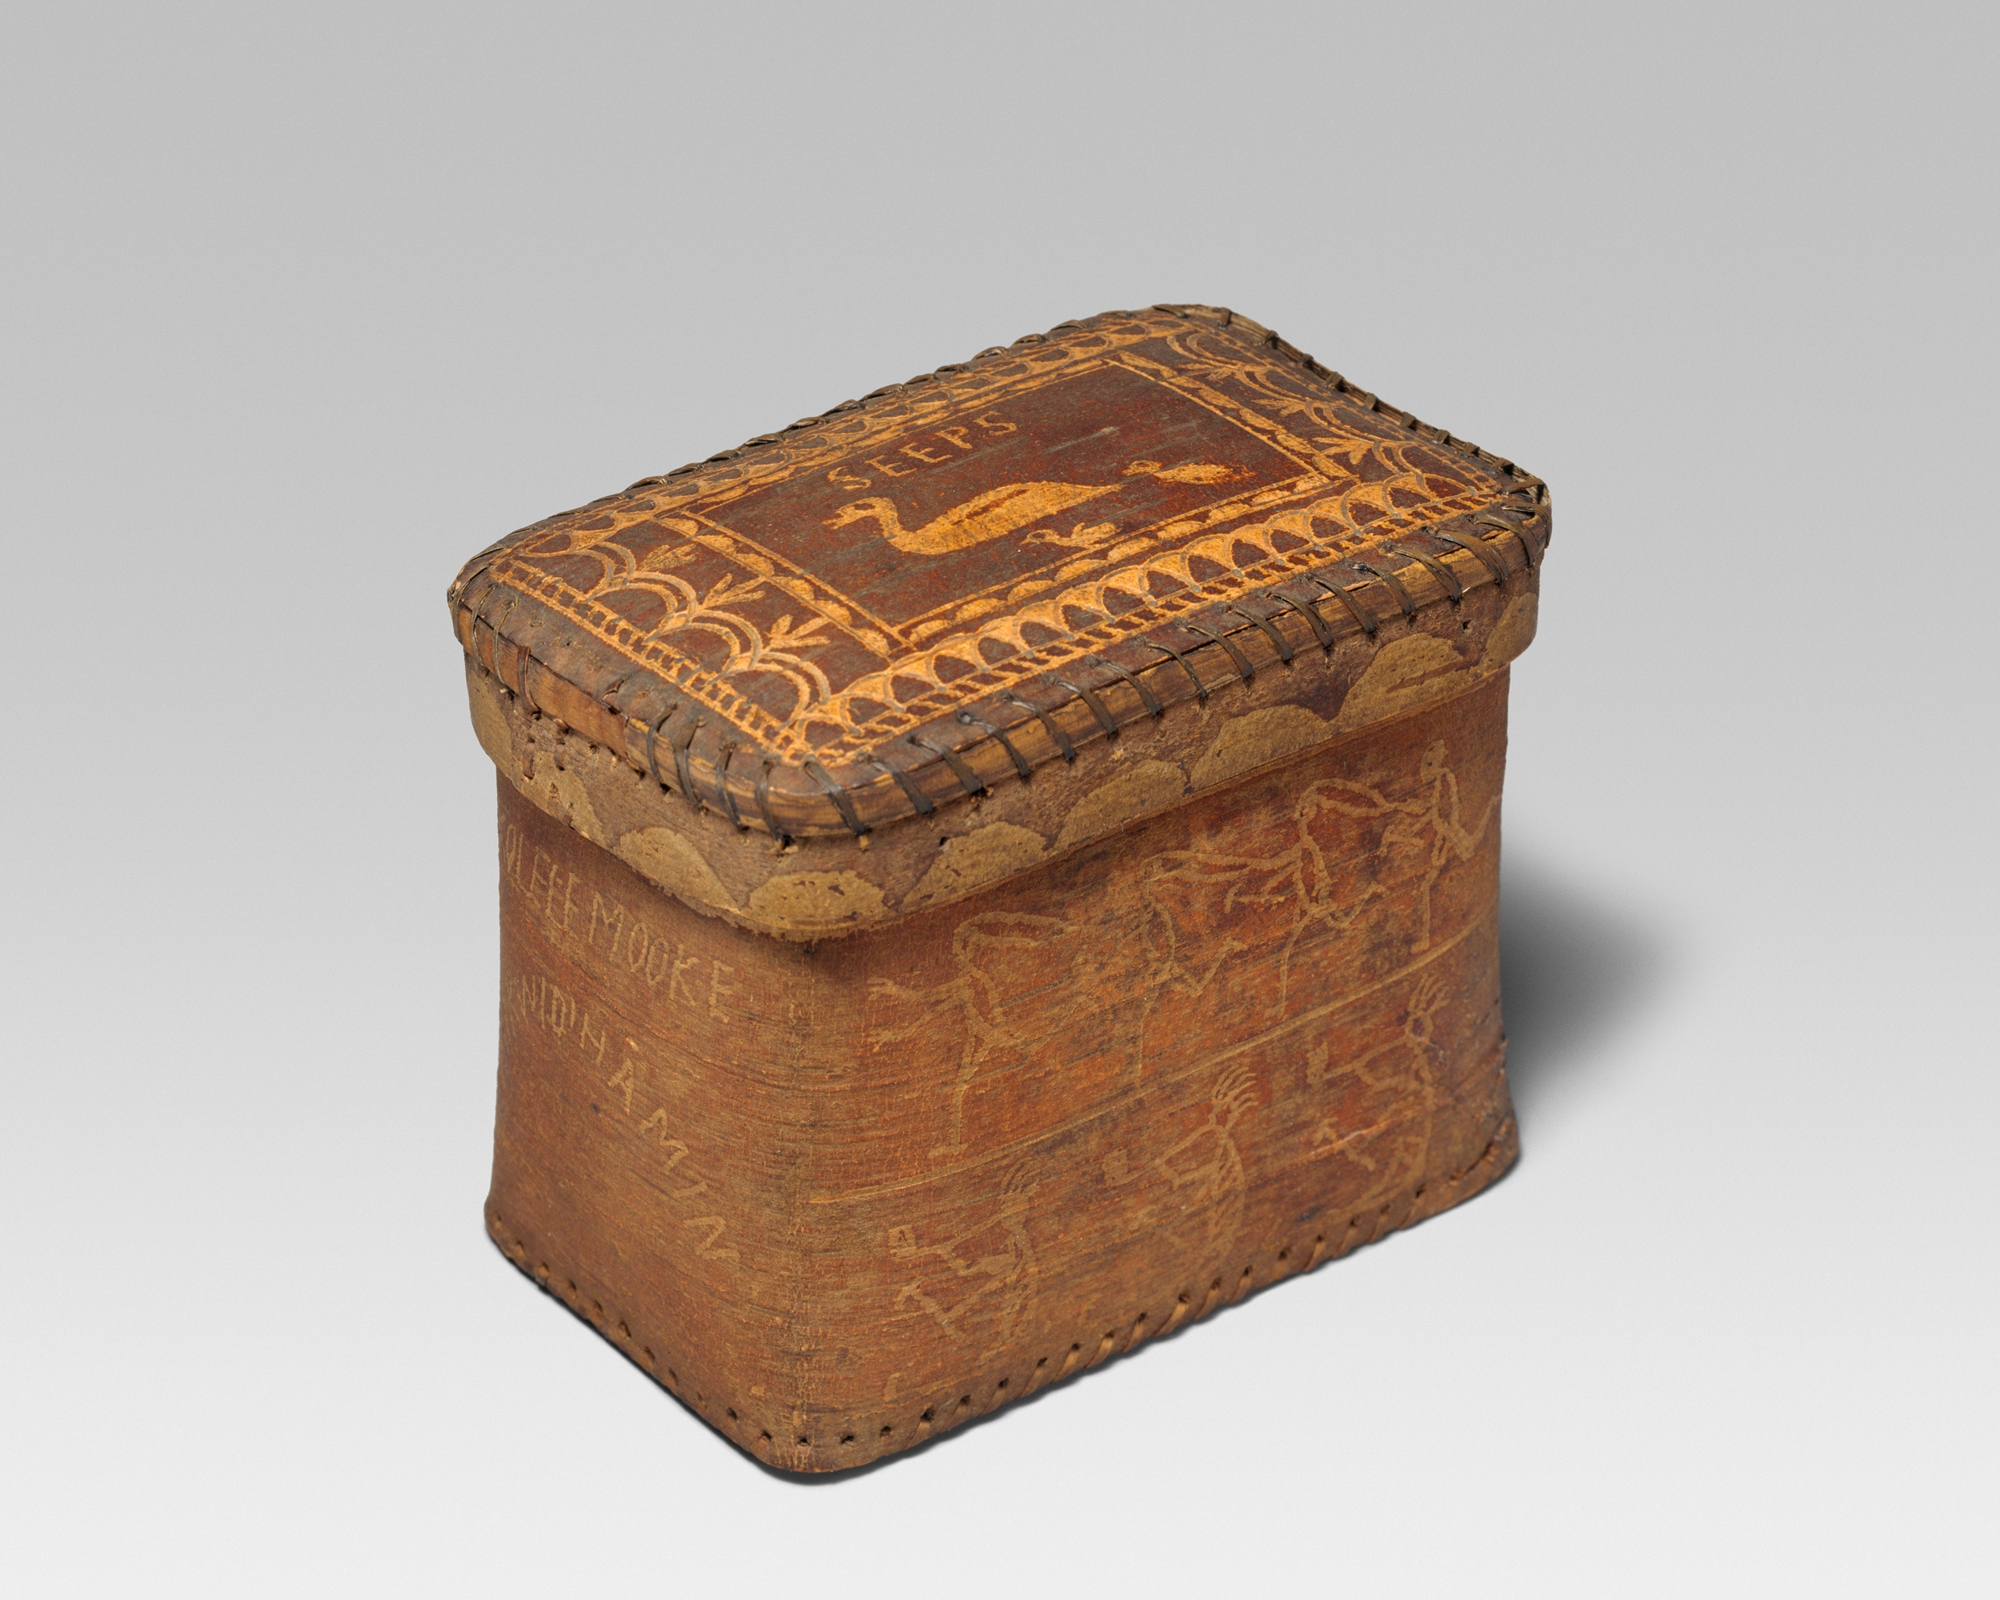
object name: box with lid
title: Lidded Box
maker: tomah joseph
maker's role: artist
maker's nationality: native american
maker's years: 1837-1914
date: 1890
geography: united states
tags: birds